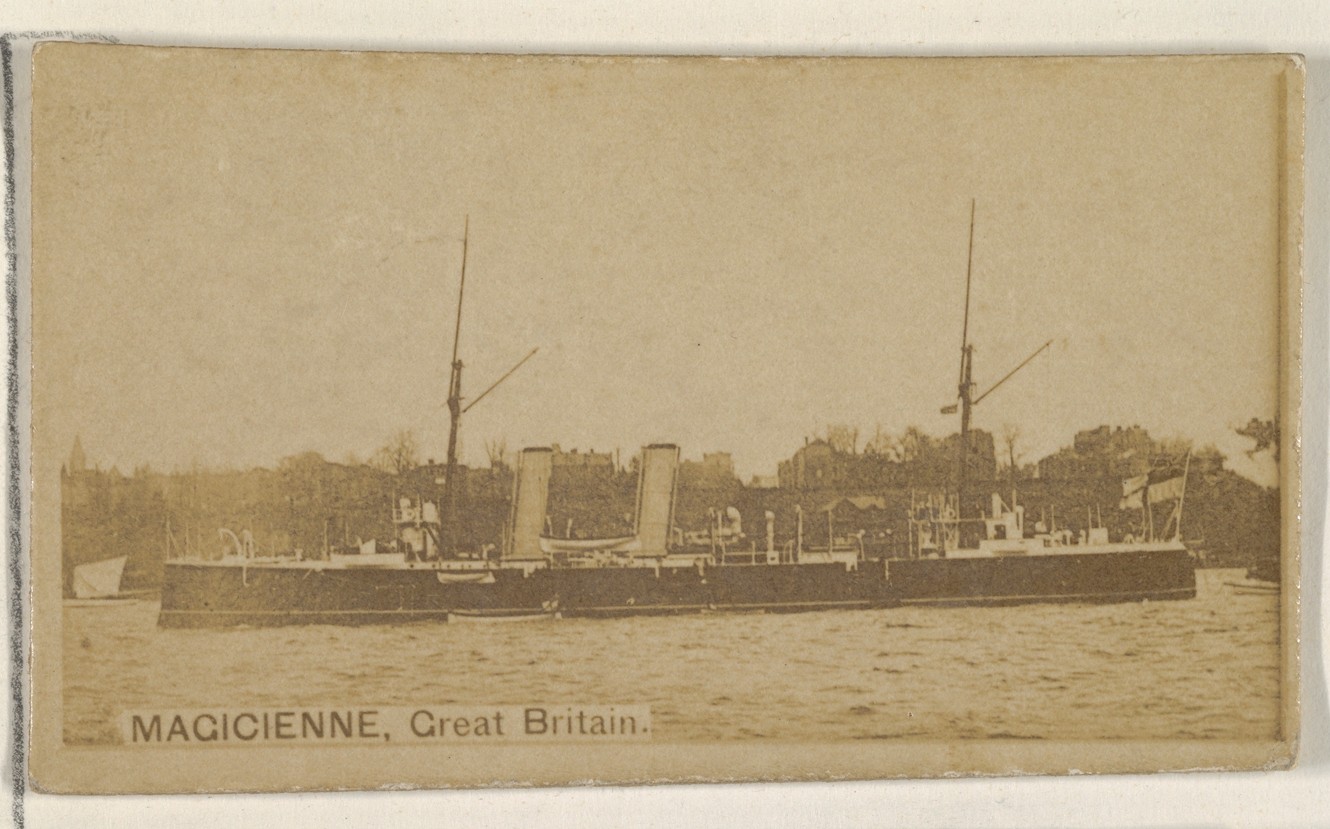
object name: photograph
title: Magicienne, Great Britain, from the Famous Ships series (N50) for Virginia Brights Cigarettes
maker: allen & ginter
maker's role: publisher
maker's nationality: american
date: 1895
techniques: albumen silver print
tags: ships